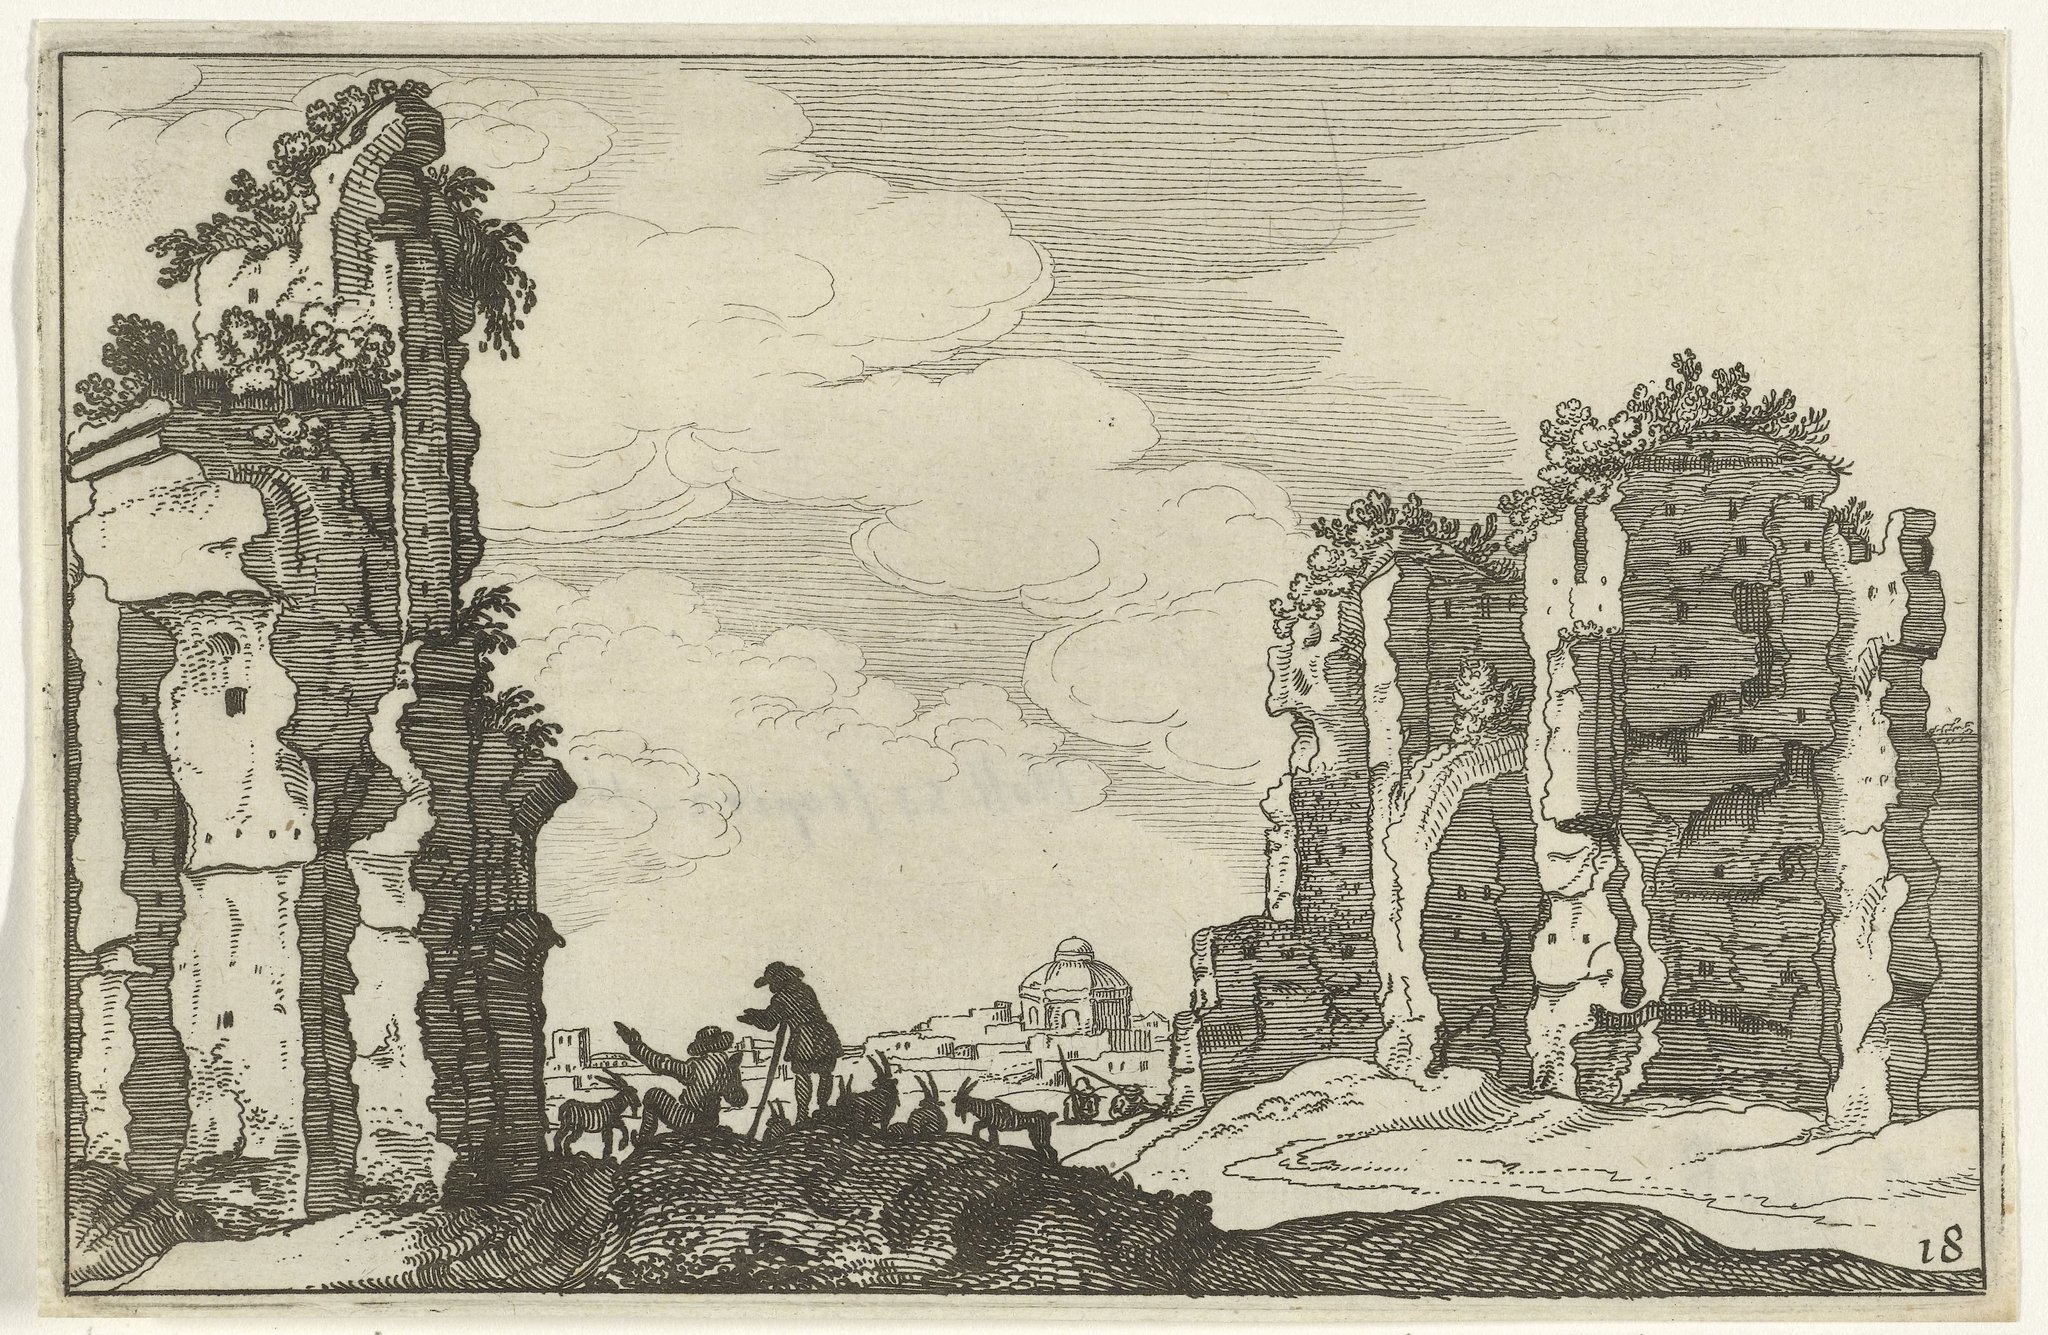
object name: print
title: Ruïne van de thermen van Caracalla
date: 1618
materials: paper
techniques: etching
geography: amsterdam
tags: herding, herdsman, herdswoman, shepherd, shepherdess, cowherd, etc., landscape with ruins (+ city(-scape) with figures, staffage), rome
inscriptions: collector's mark: Lugt 2228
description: De begroeide ruïnes van de thermen van Caracalla in Rome. Op de voorgrond twee herders met een kudde geiten. Op de achtergrond de stad Rome. Prent maakt deel uit van een serie Romeinse ruïnes en kustlandschappen naar een prentserie van Willem van Nieulandt.